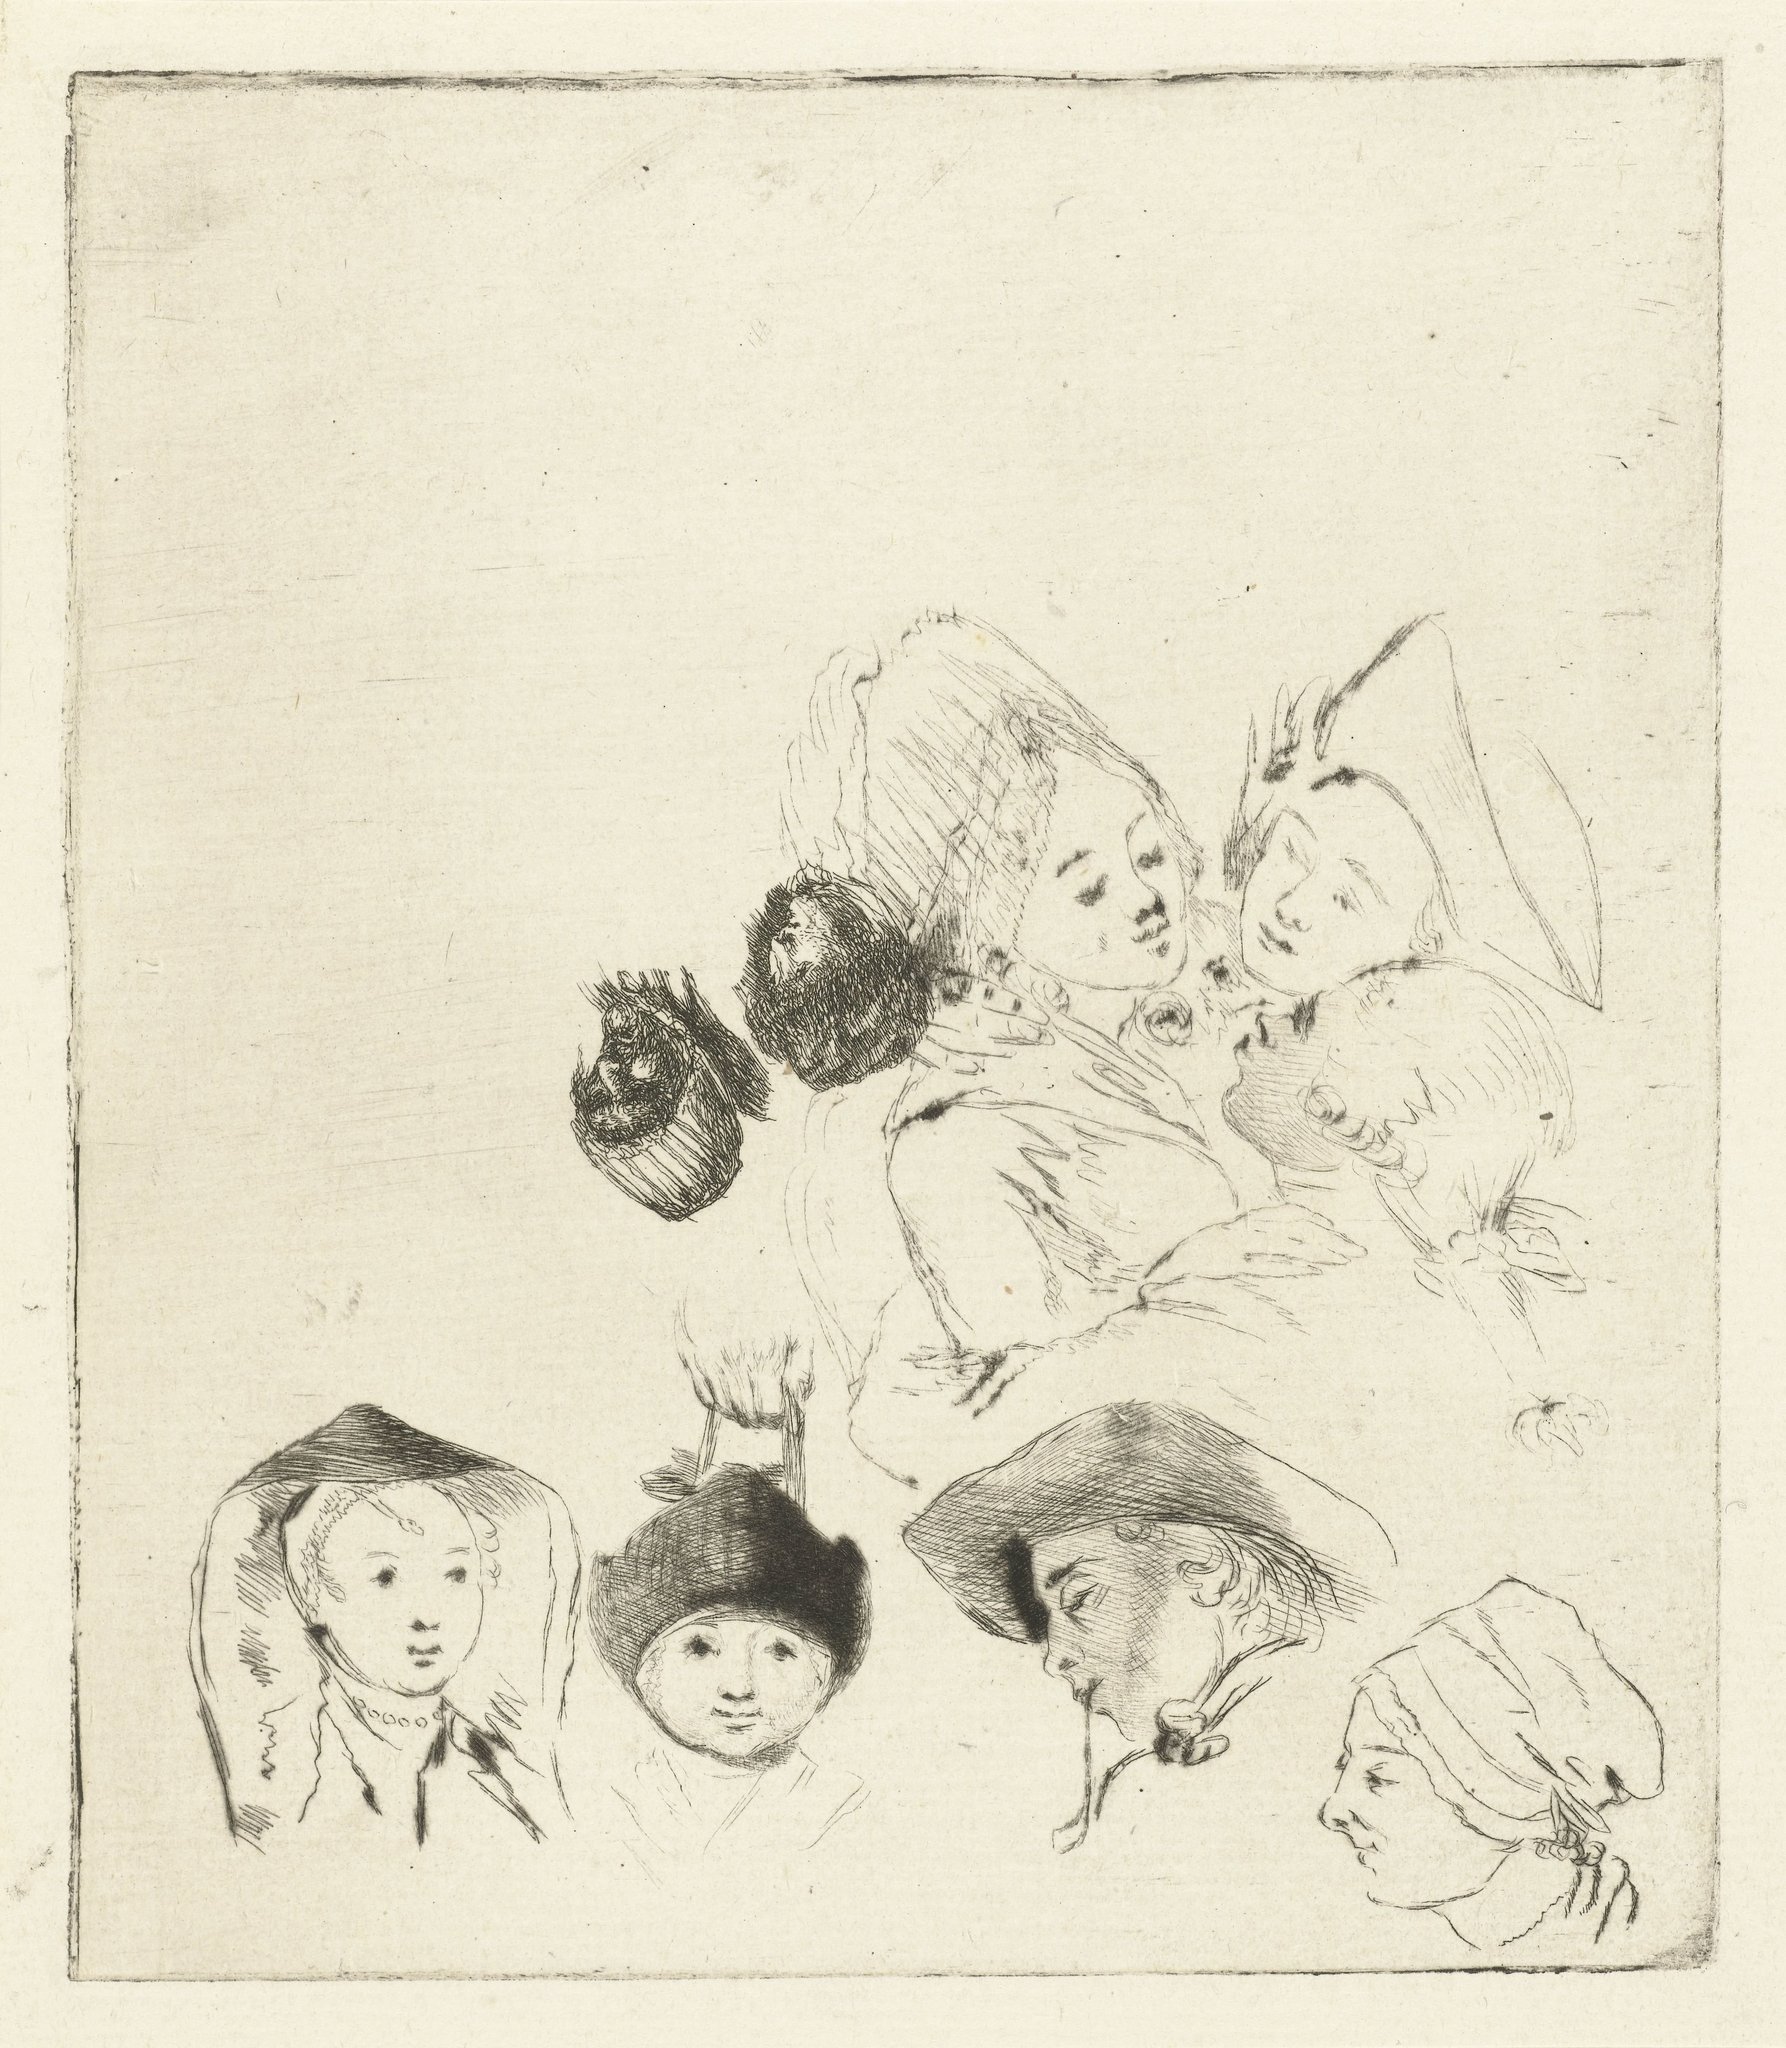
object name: print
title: Studieblad met negen hoofden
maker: louis bernard coclers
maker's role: draughtsman, print maker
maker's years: 1741-1817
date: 1756-1817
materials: paper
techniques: drypoint, etching